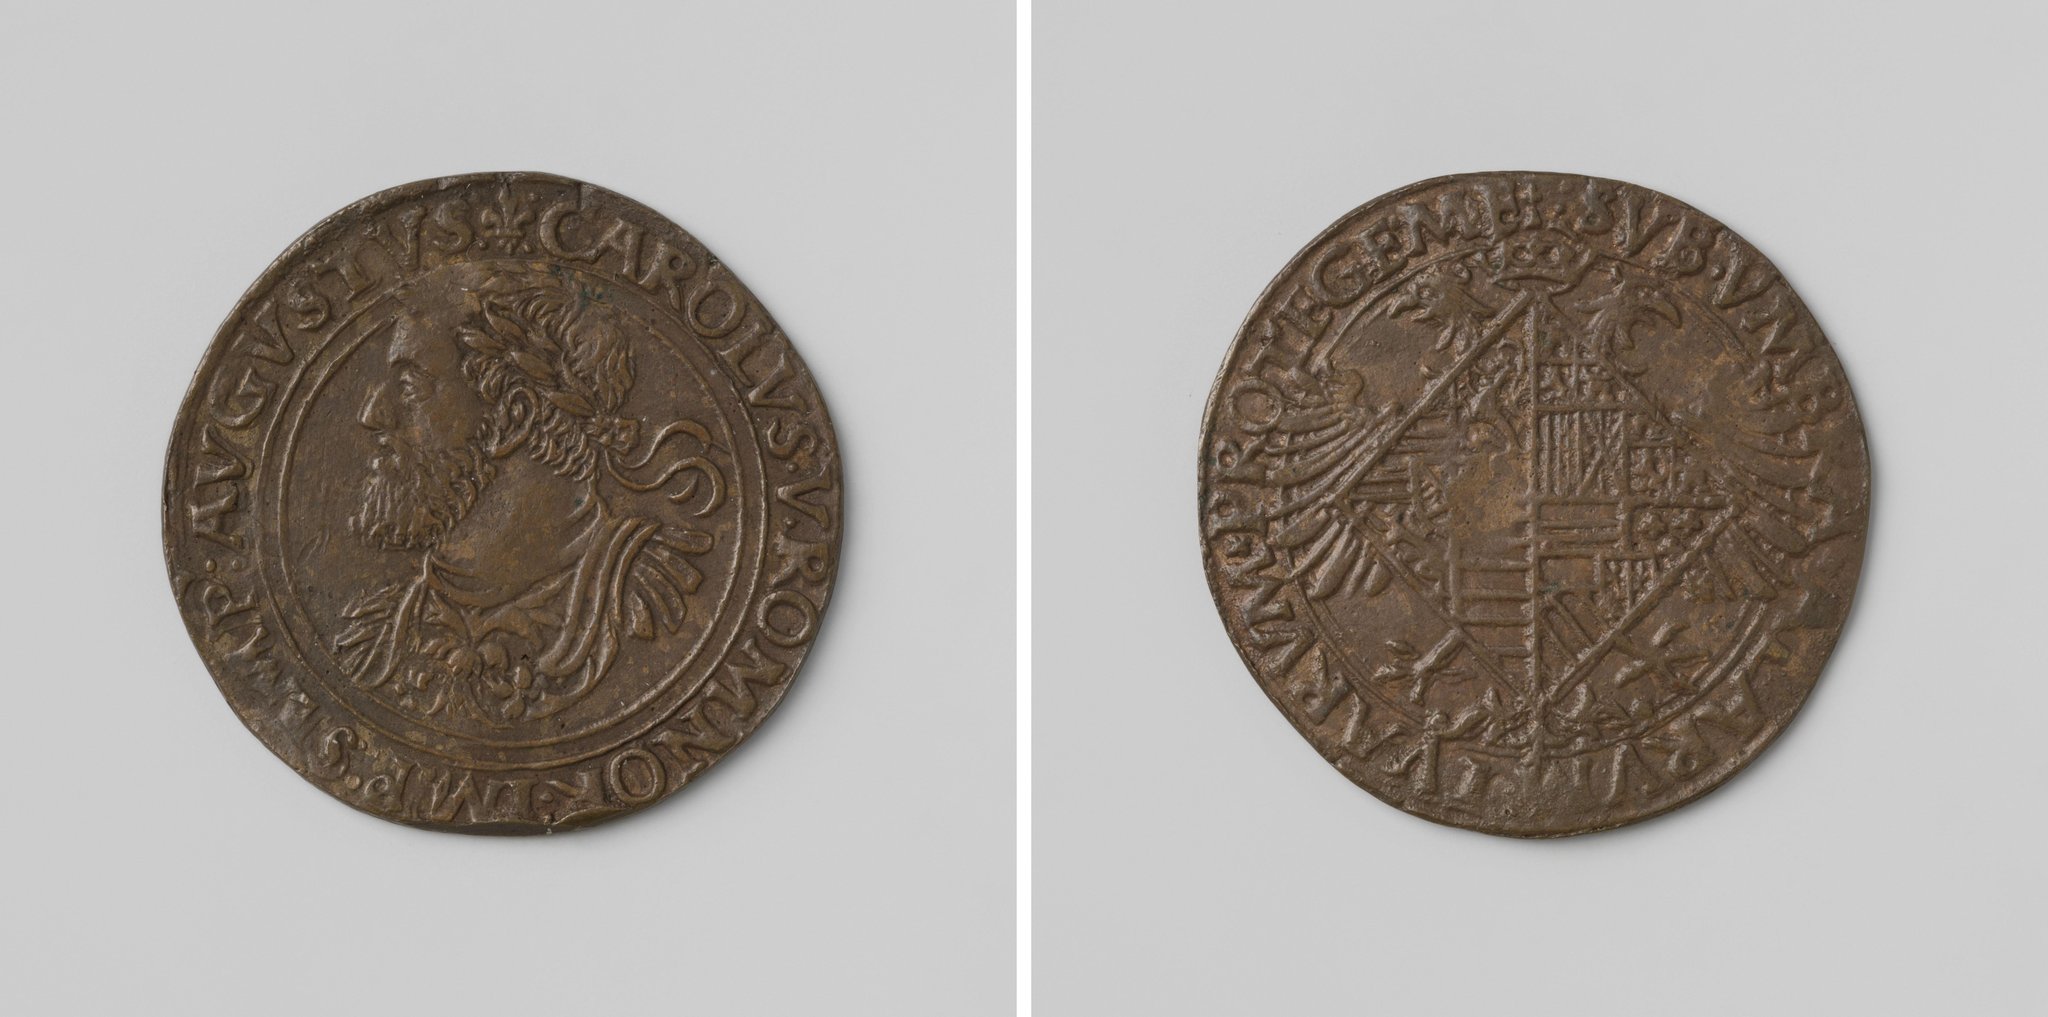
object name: jeton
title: Karel V, Duits keizer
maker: Anonymous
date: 1540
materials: copper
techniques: striking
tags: ghent, charles v (holy roman emperor and king of spain)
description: Koperen penning. Voorzijde: borststuk man met lauwerkrans binnen omschrift. Keerzijde: tweekoppige adelaar onder kroon met ruitvormig wapenschild binnen omschrift